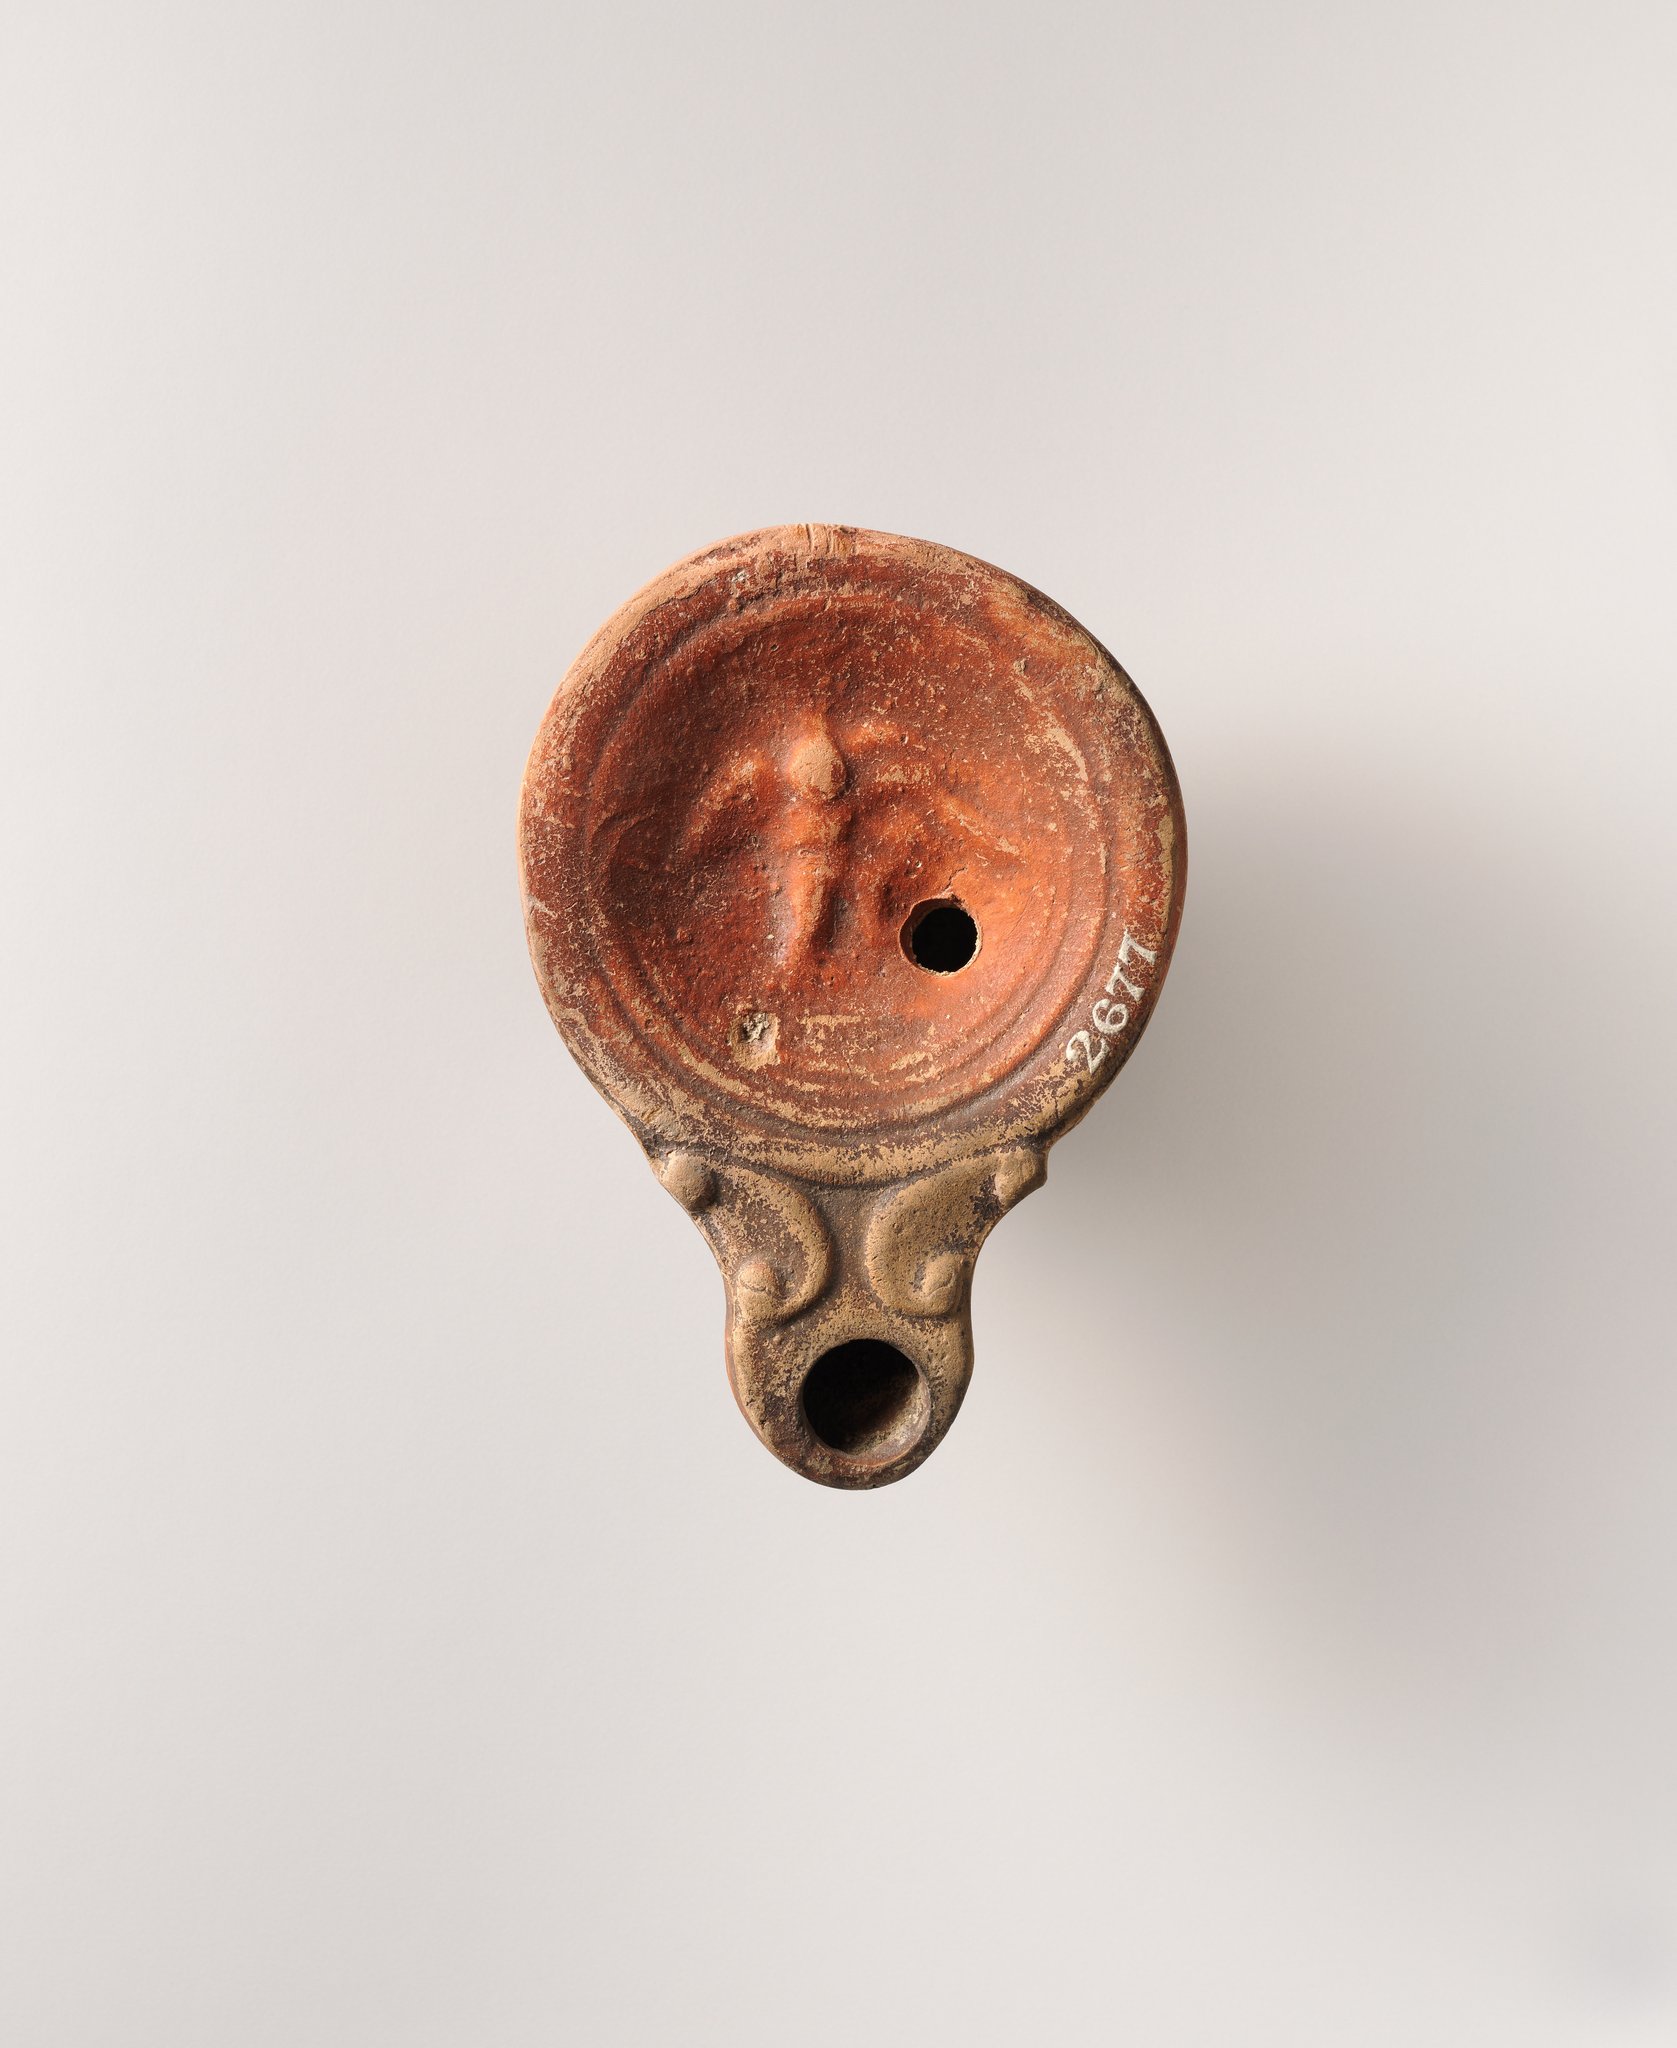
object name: lamp, concave top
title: Terracotta oil lamp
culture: roman, cypriot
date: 40-100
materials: terracotta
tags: eros